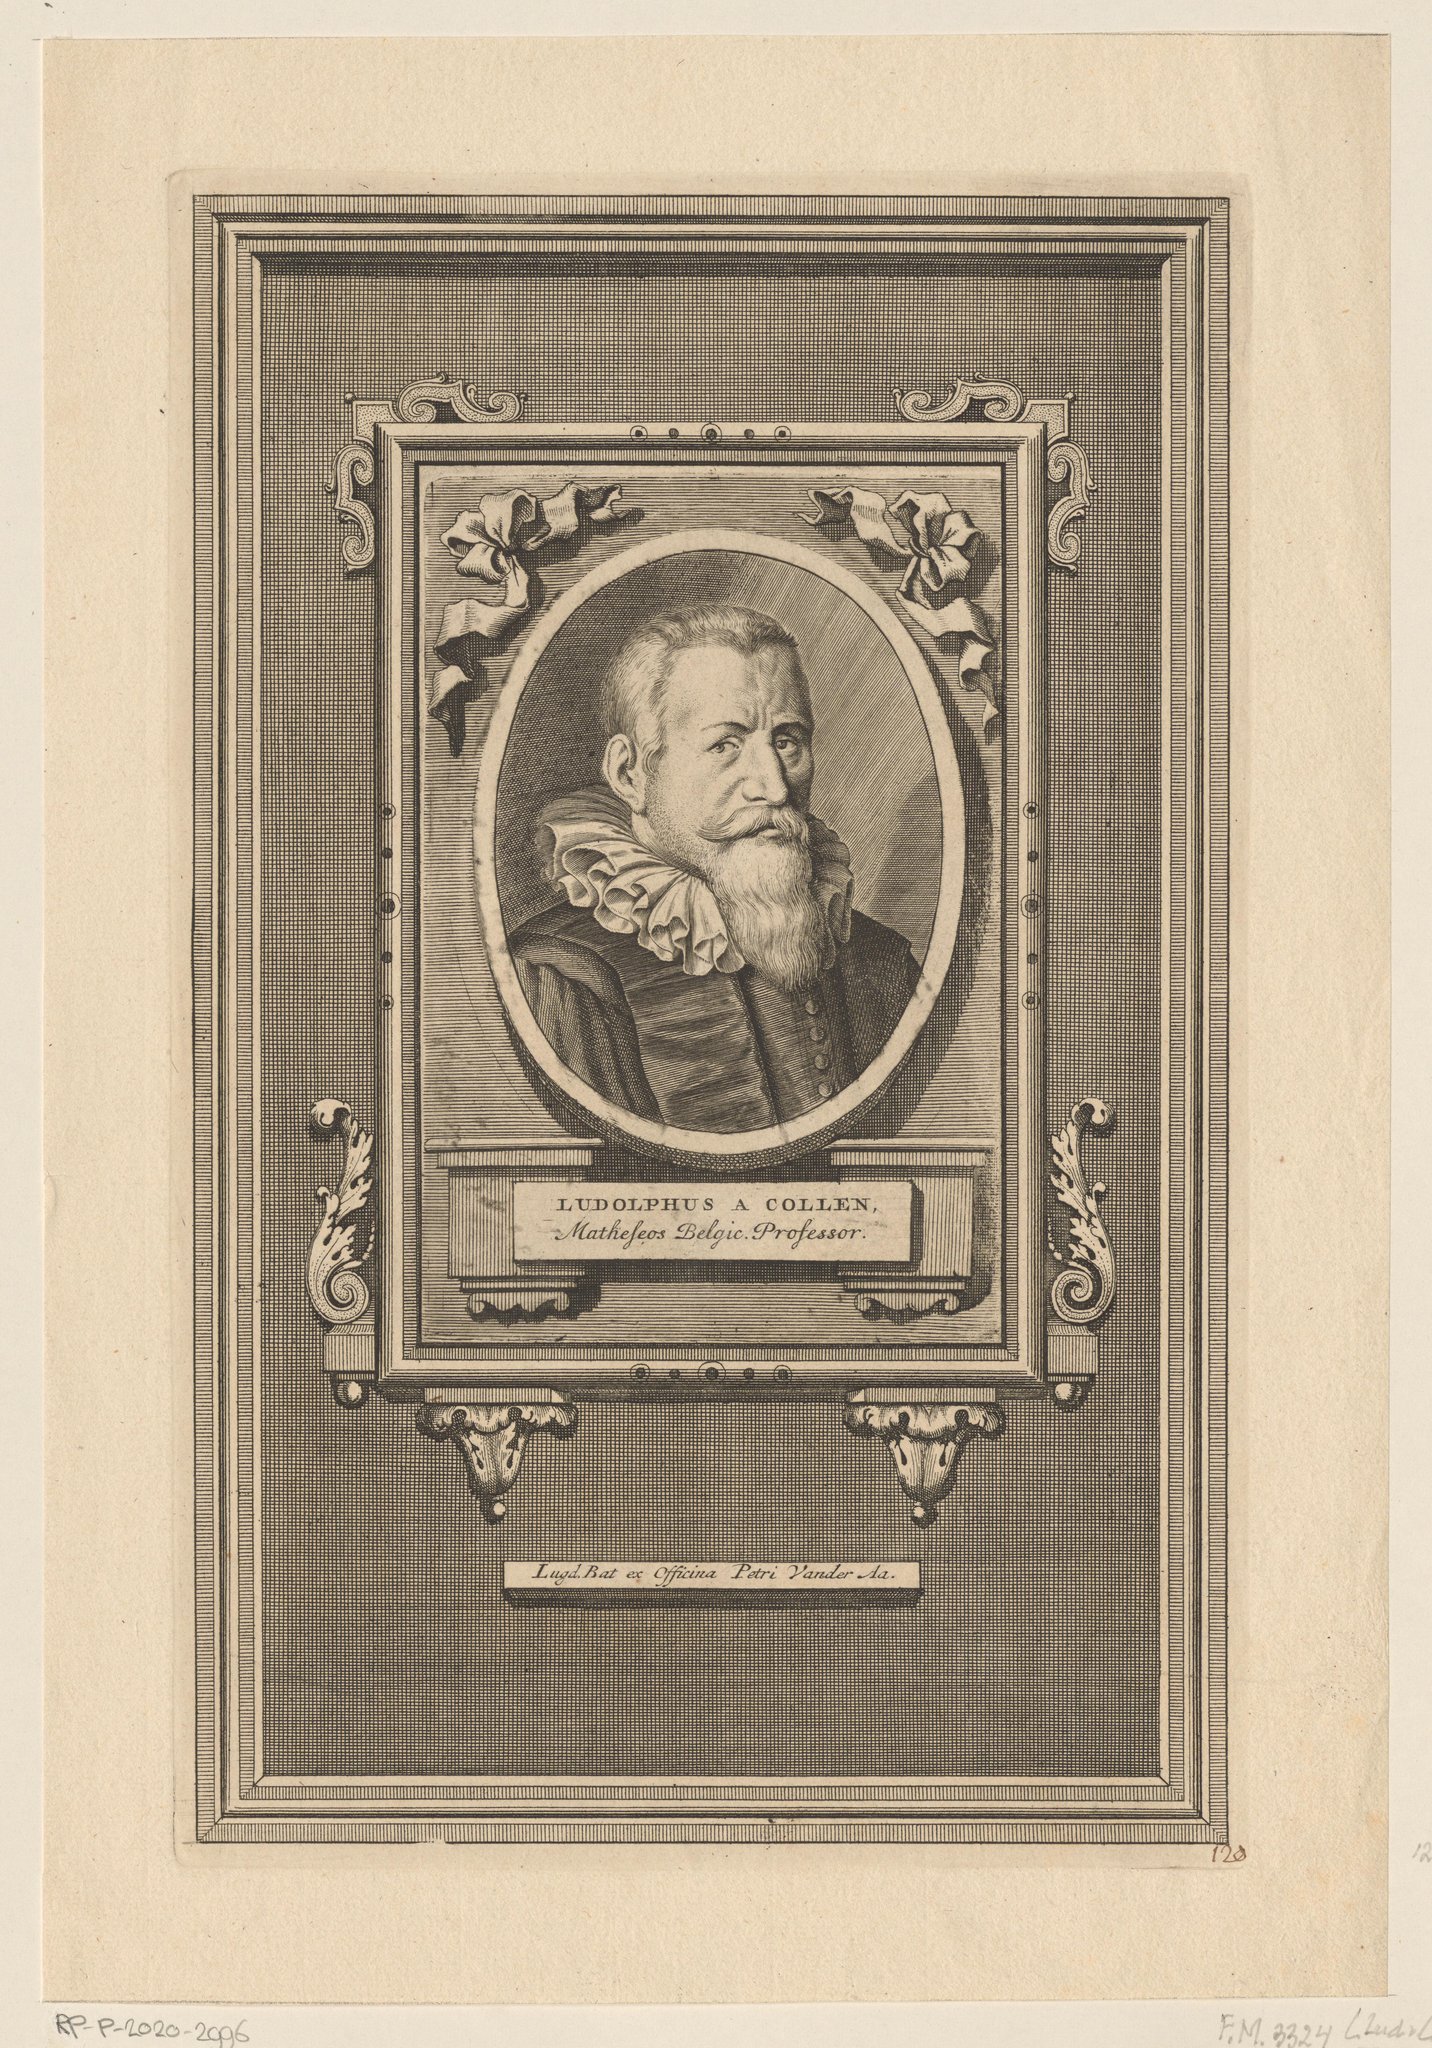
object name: print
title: Portret van Ludolph van Ceulen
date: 1668-1733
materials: paper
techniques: engraving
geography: leiden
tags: leiden, historical persons